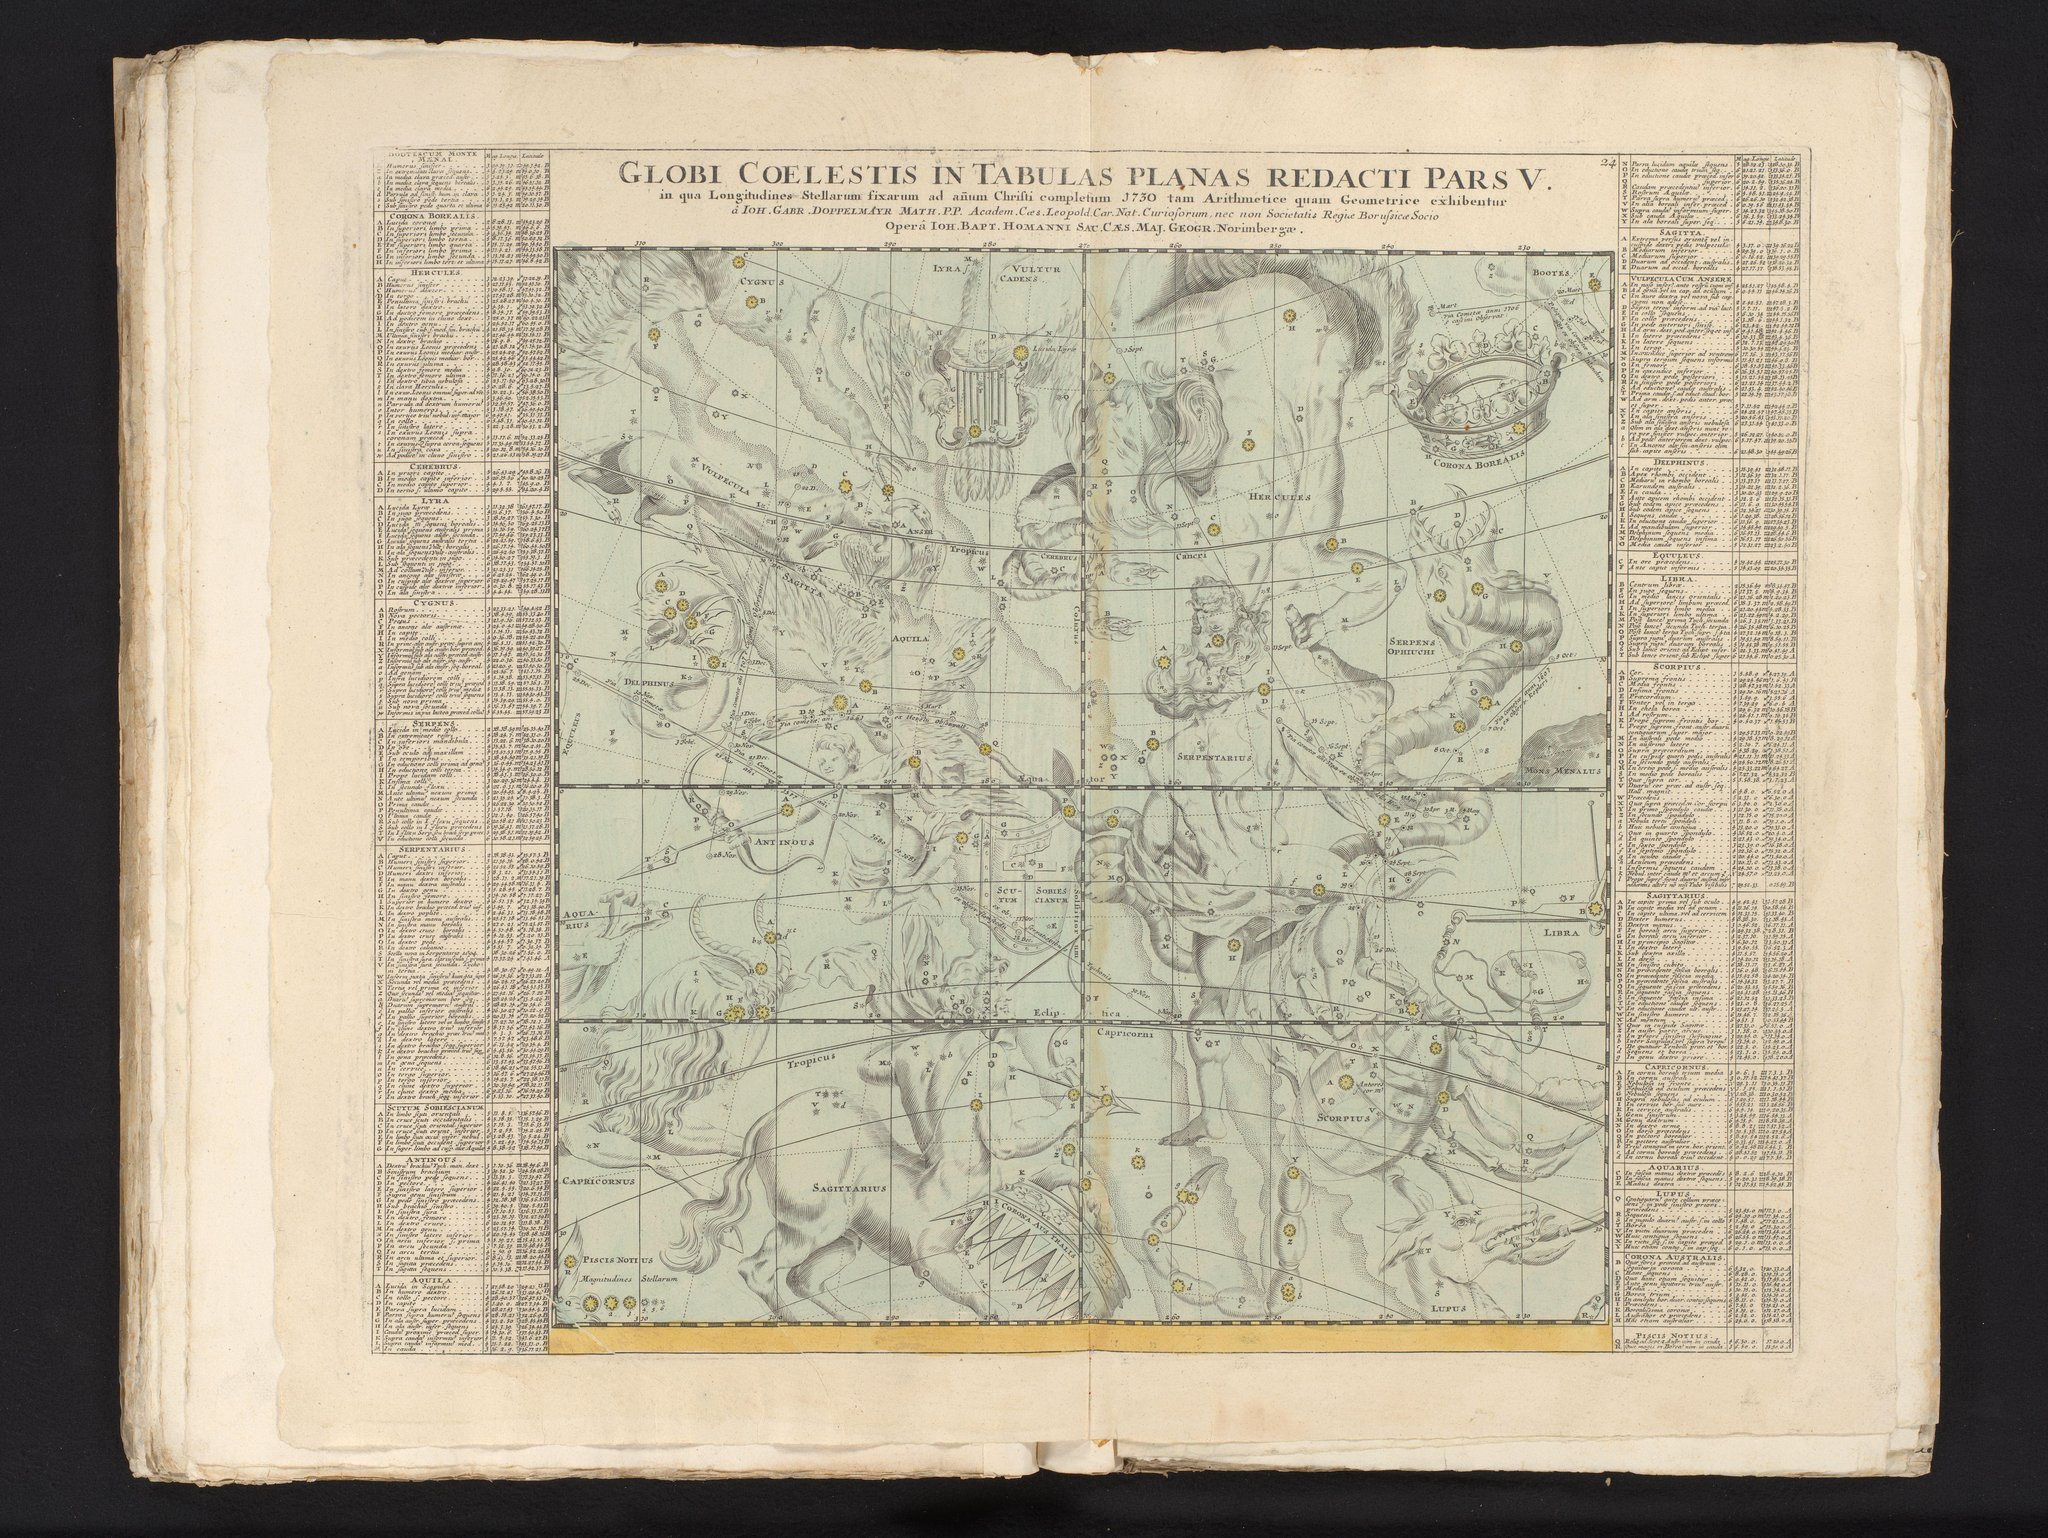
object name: print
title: Globi coelestis in tabulas planas redacti pars V, in qua longitudines (...)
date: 1742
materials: paper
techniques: engraving, etching, hand coloring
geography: nuremberg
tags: zodiac; the twelve zodiacal signs together, star-chart, star map